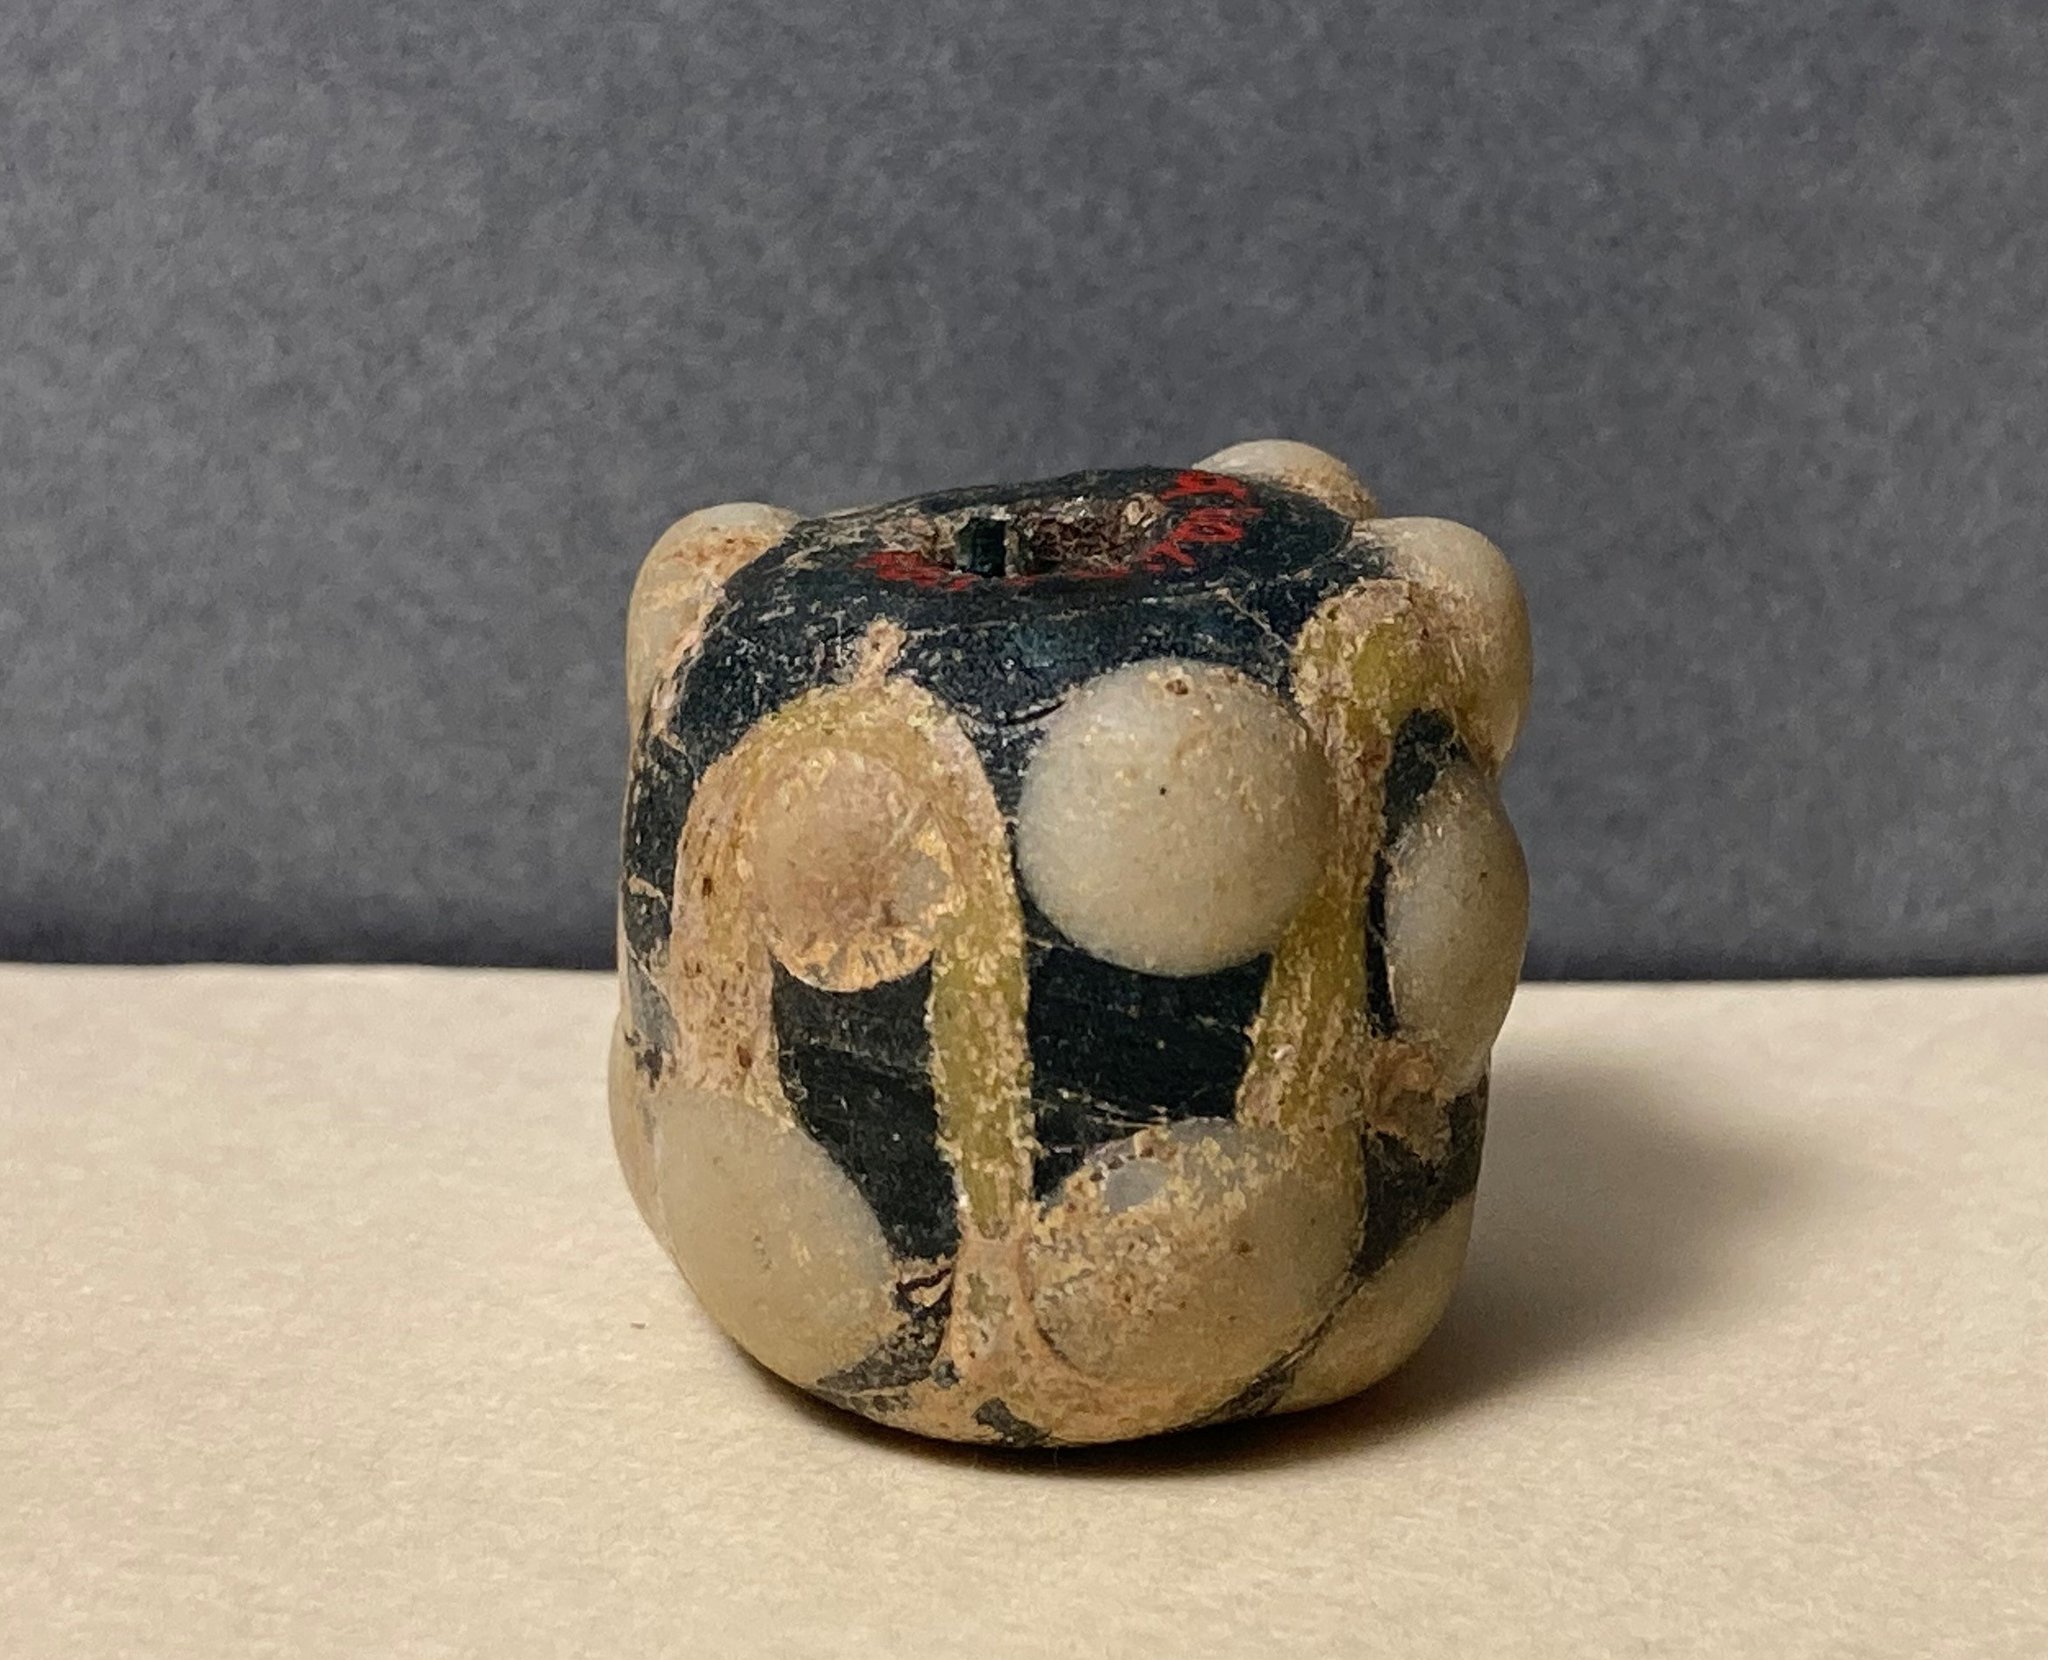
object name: bead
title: Beads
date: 701-1000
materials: glass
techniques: luster painting, stain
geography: iran